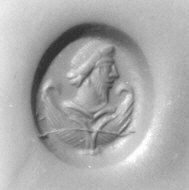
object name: stamp seal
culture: sasanian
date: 201-700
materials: stone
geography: iran or mesopotamia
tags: men,profiles